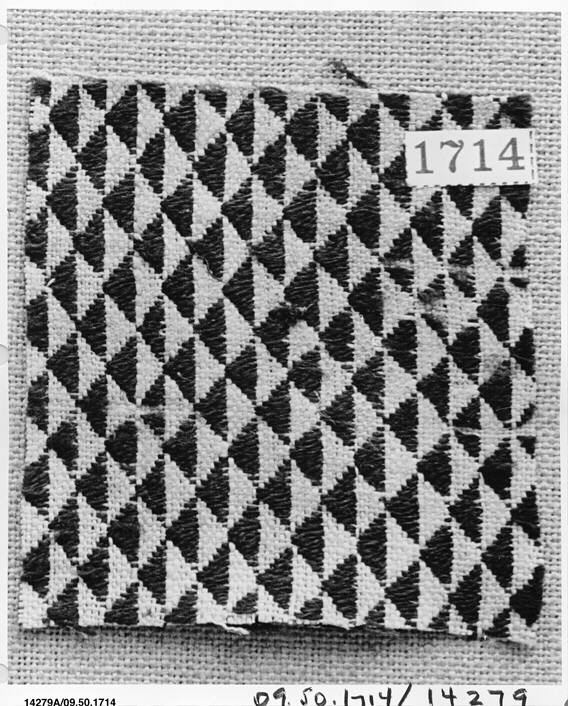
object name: fragment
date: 1801-1900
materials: wool